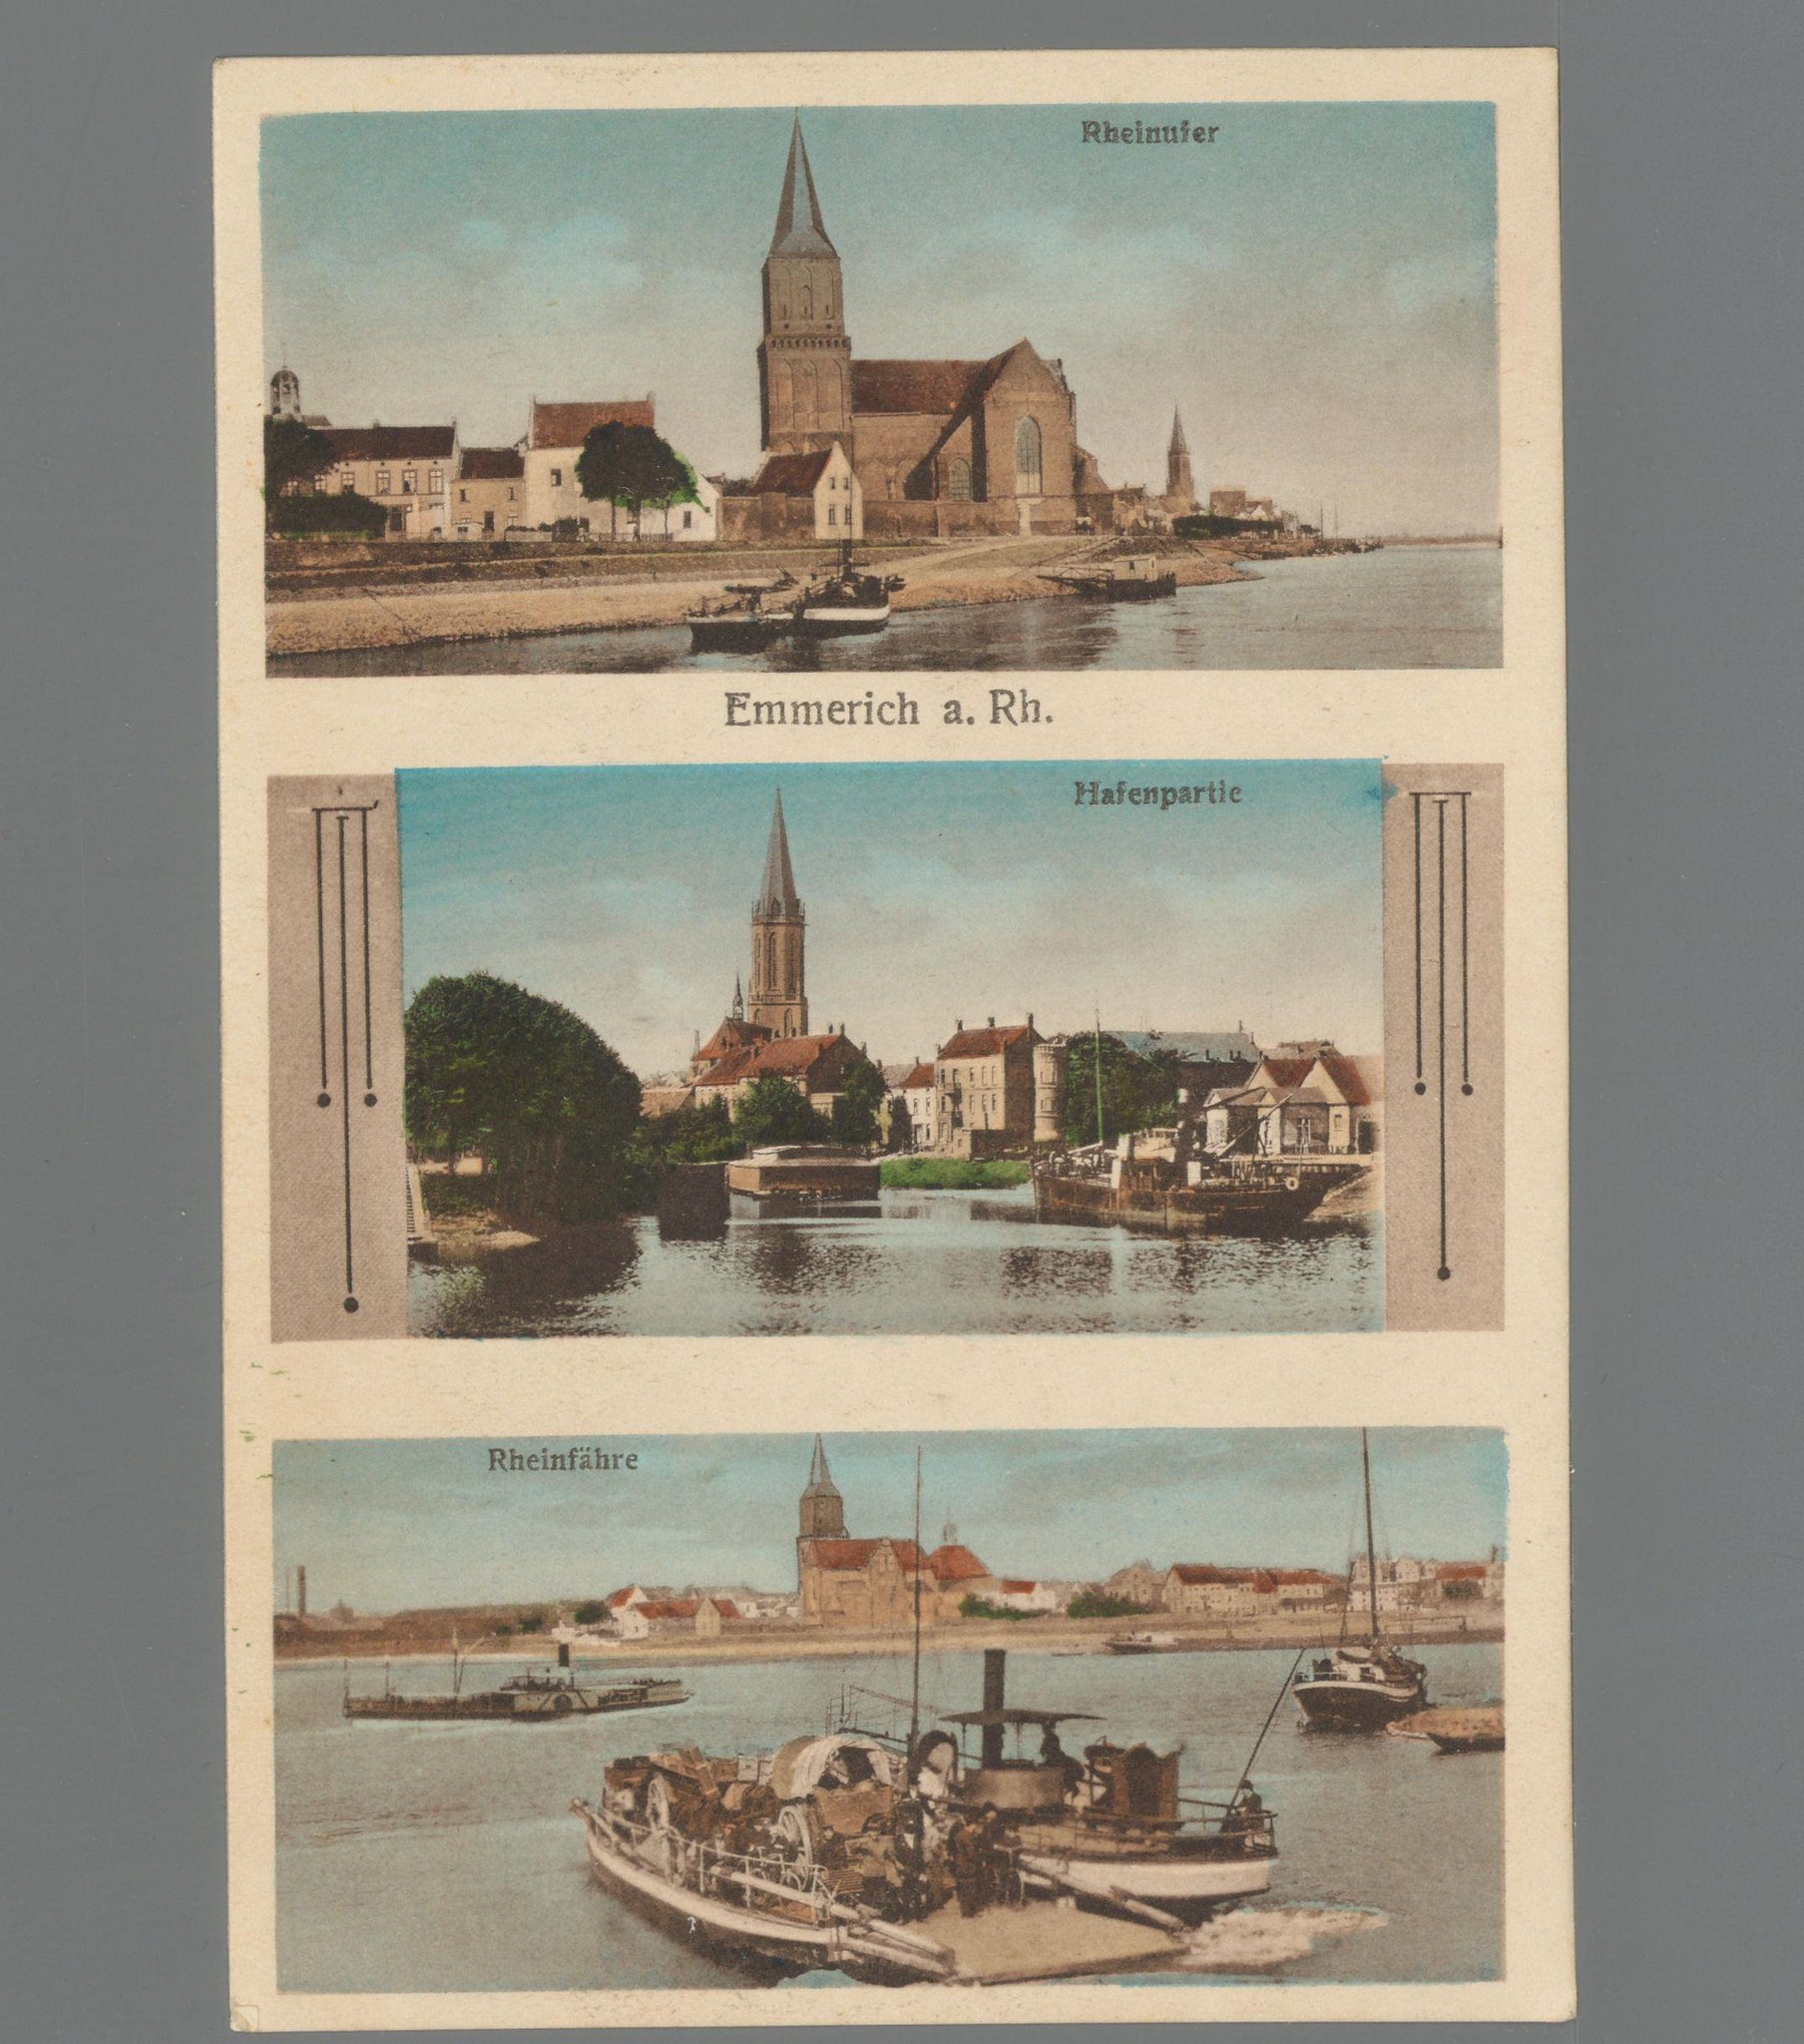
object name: photomechanical print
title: Emmerich a. Rh.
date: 1905-1930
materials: cardboard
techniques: photograph, lithograph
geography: emmerik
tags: city-view, and landscape with man-made constructions, ships (in general), church (exterior), canals, waters (in city)